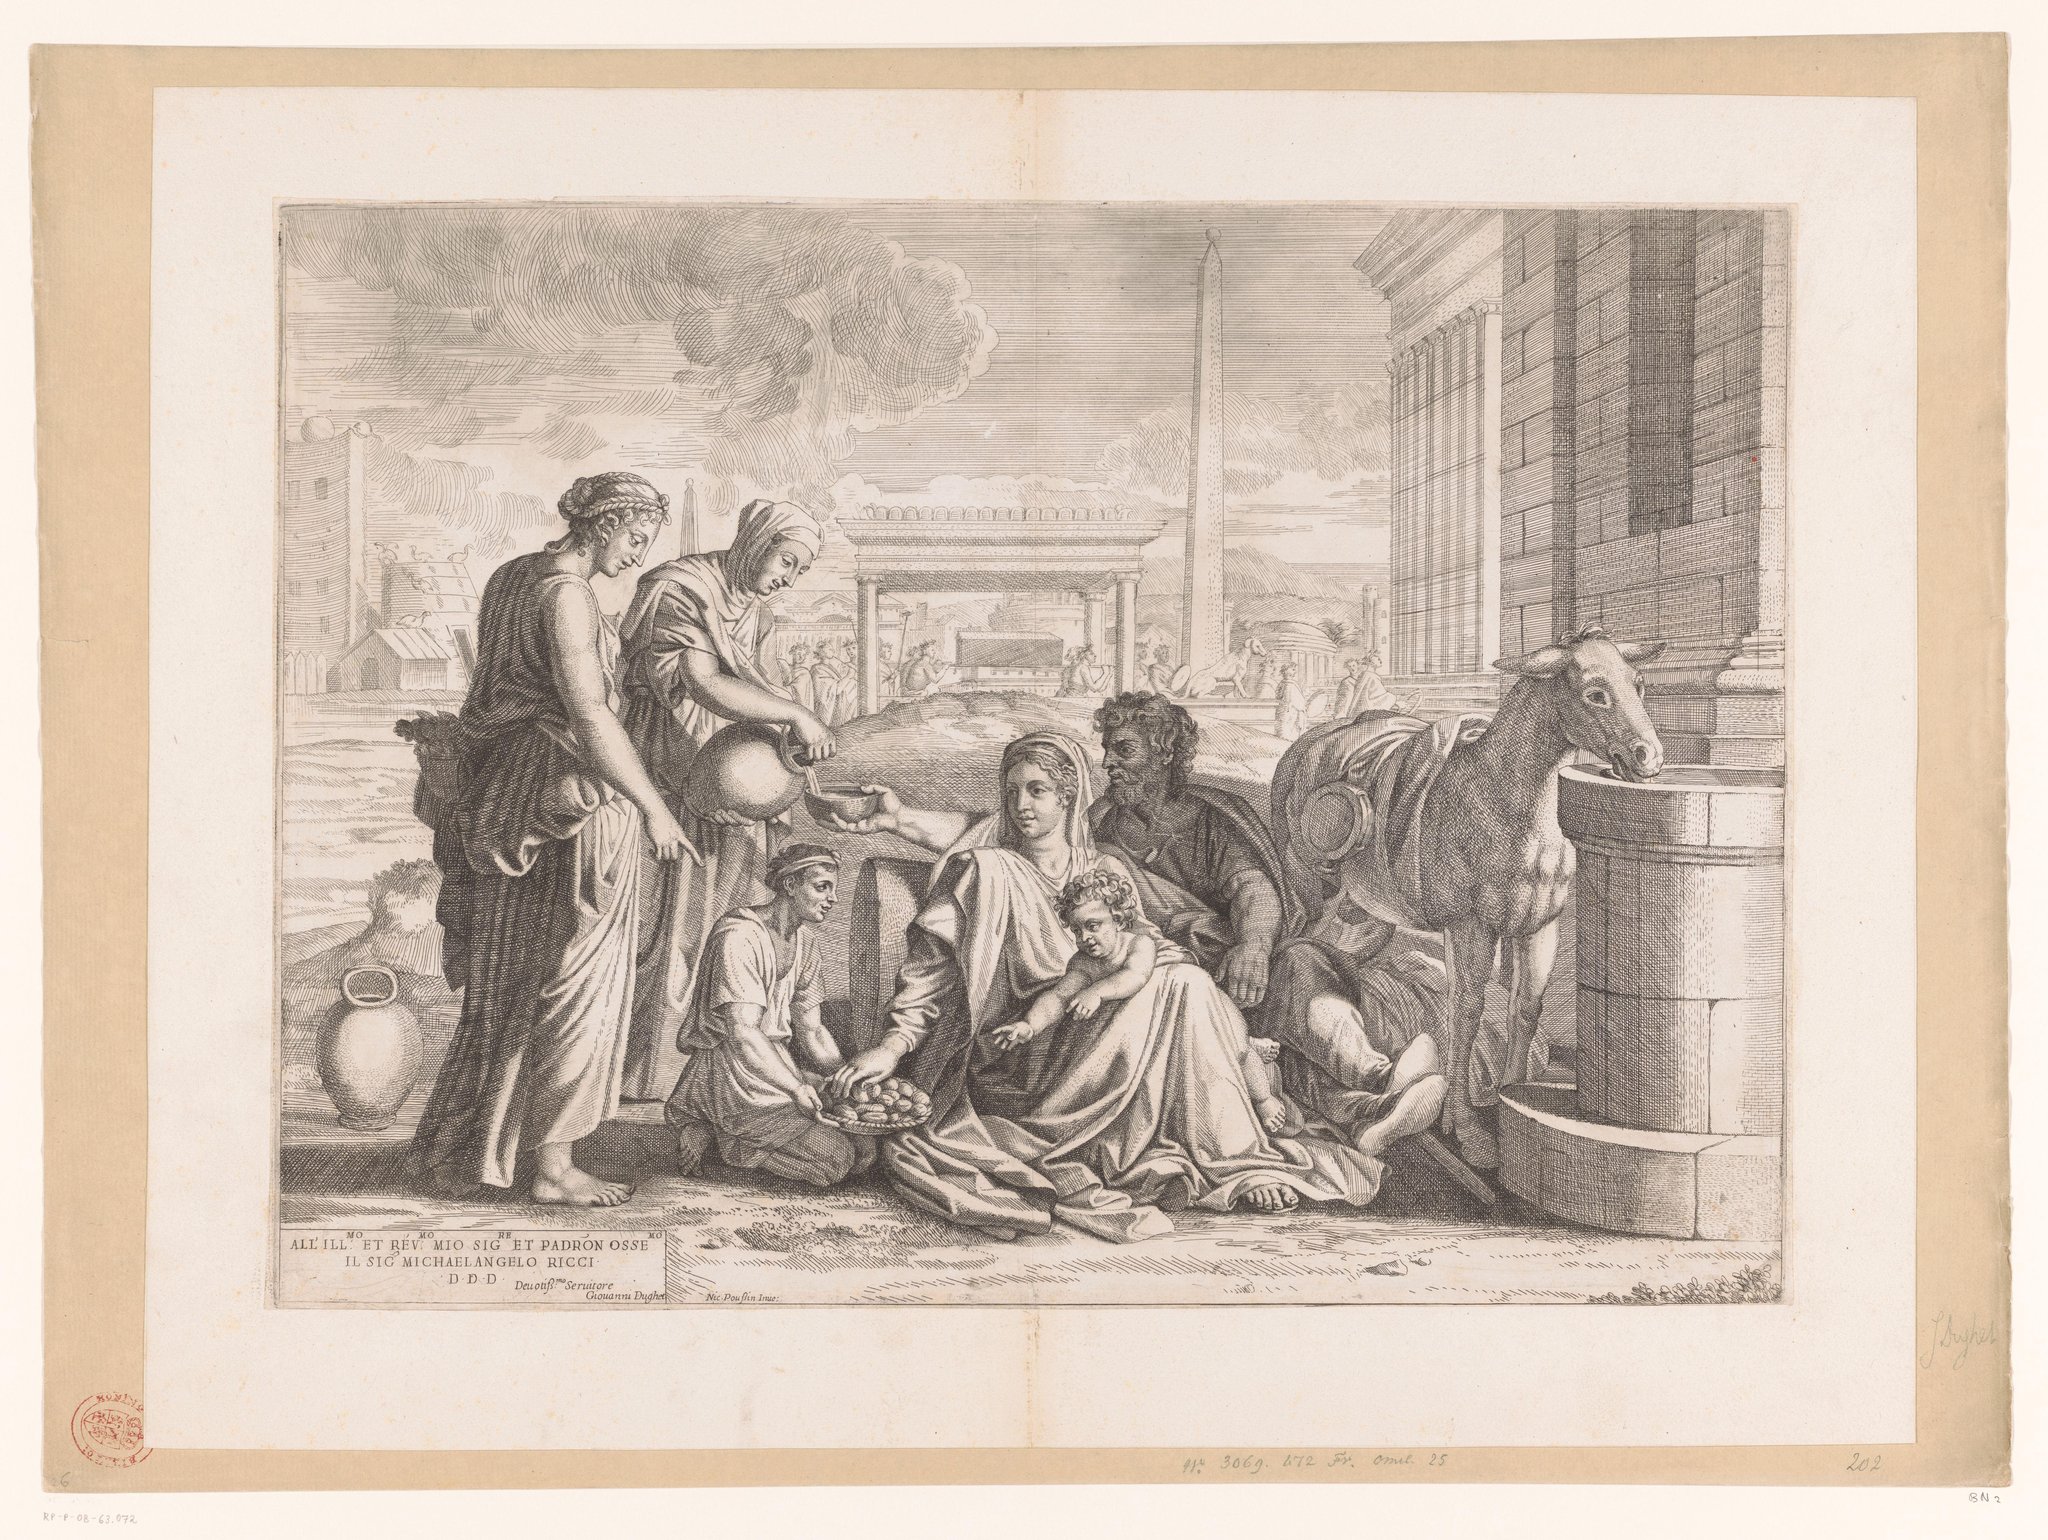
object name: print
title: Rust van de Heilige Familie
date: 1625-1679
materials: paper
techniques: engraving, etching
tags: holy family, and derived representations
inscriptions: collector's mark: Lugt 240